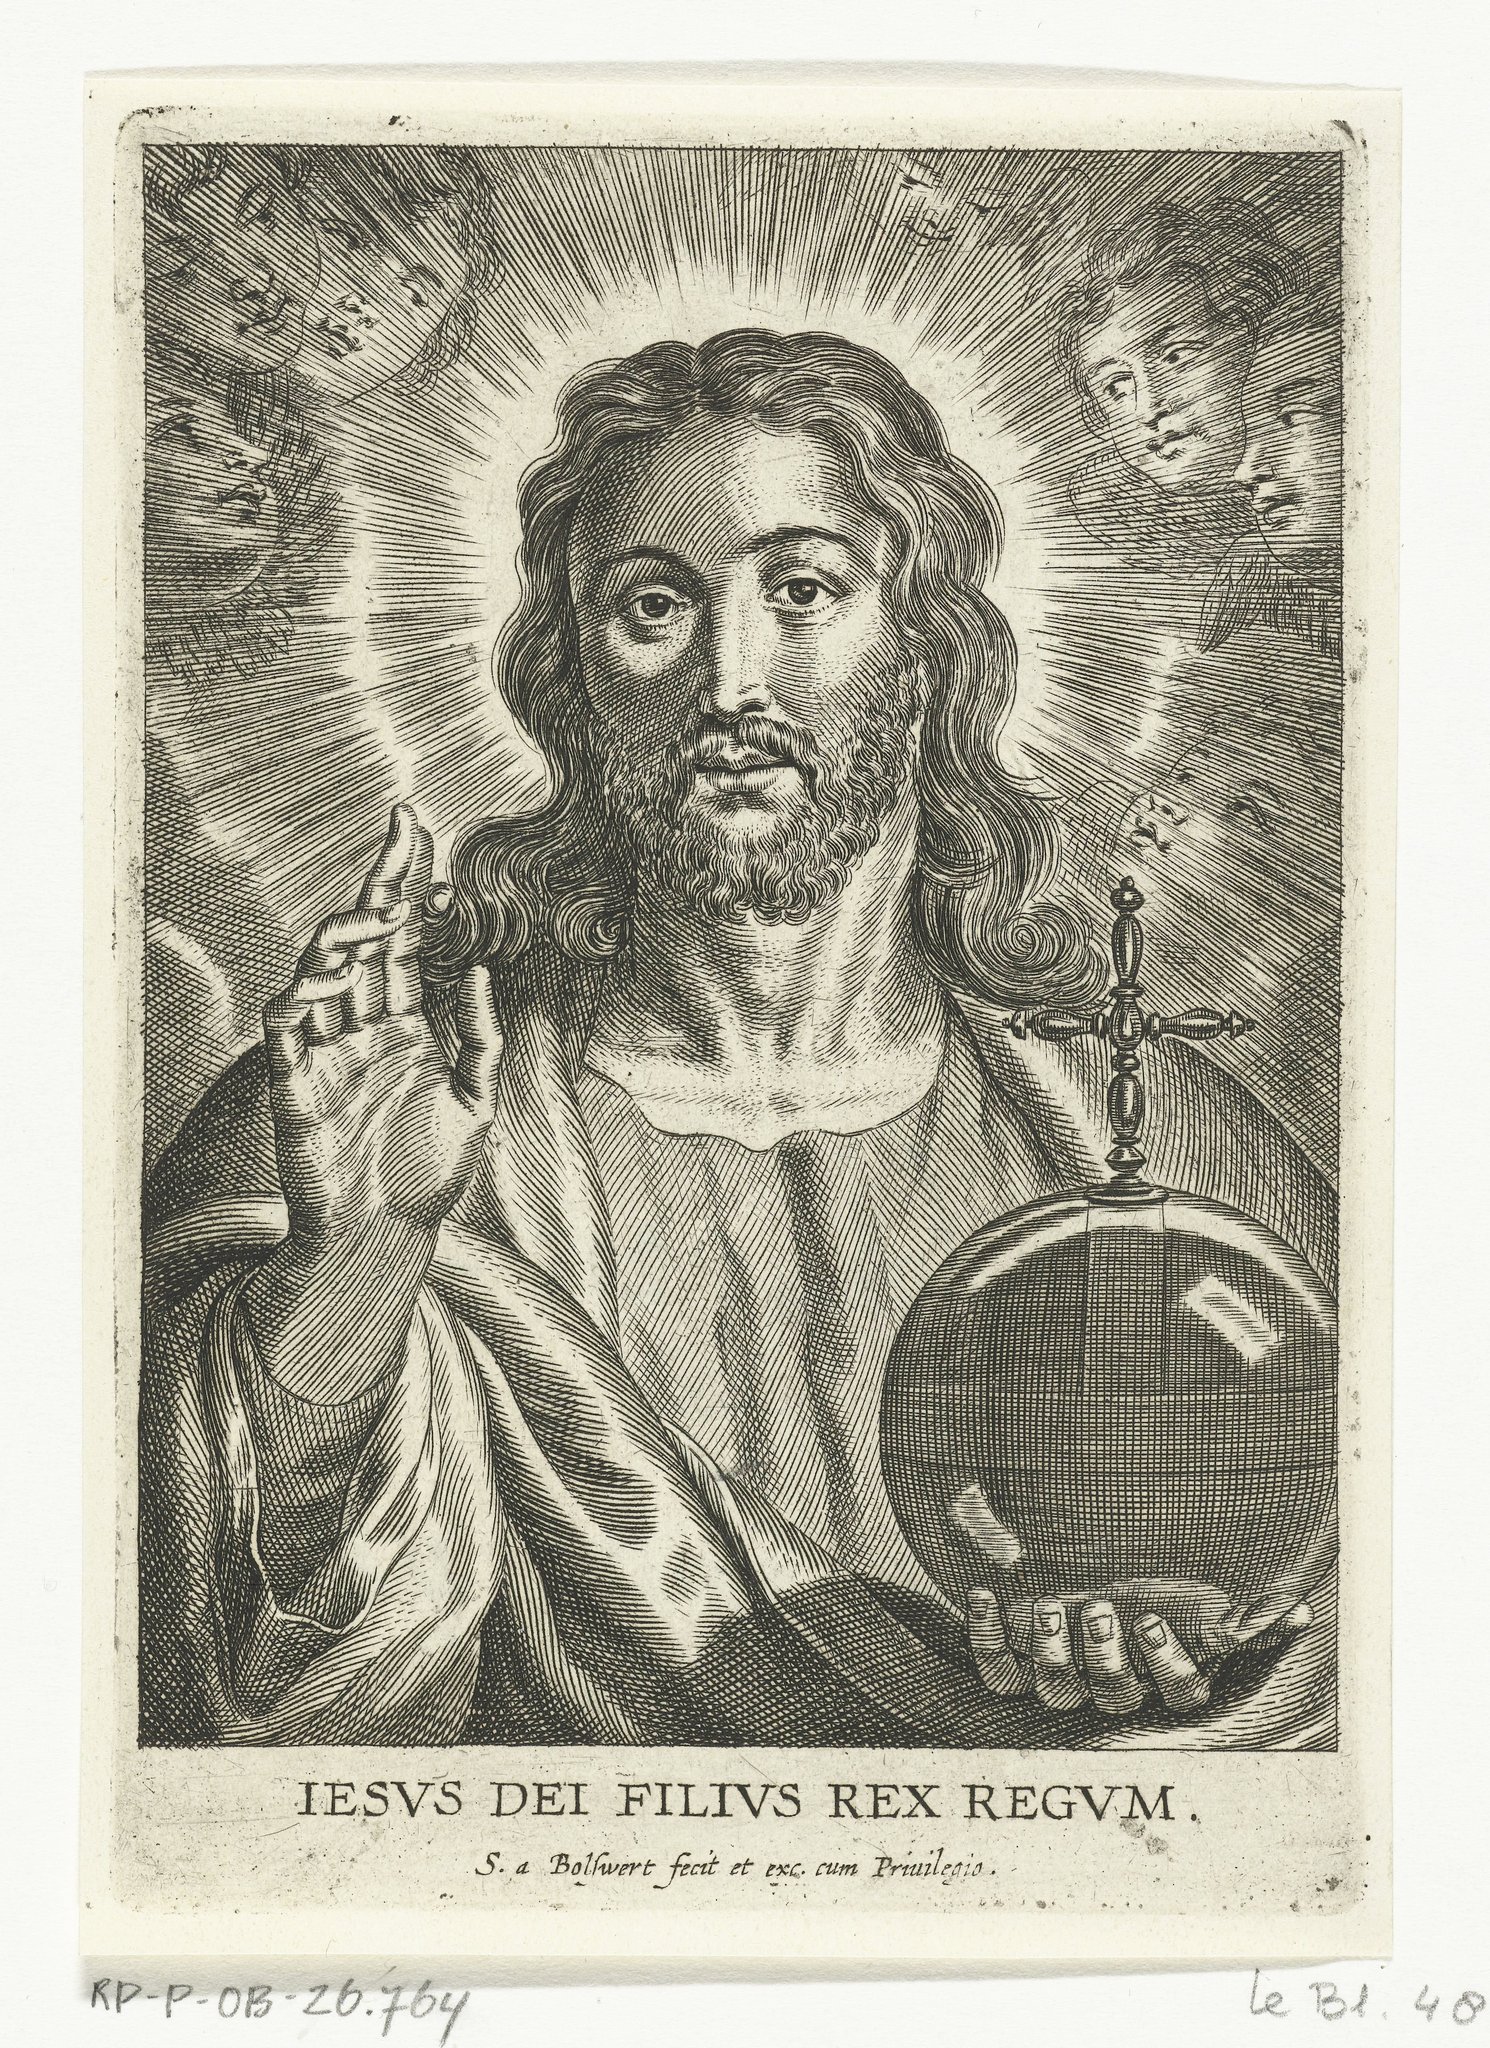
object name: print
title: Vélins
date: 1596-1659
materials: paper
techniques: engraving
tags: 'salvator mundi', making a blessing gesture; an orb in his hand or at his feet (+ angel(s))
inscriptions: collector's mark: Lugt 2228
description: Prent uit serie Vélins met negentig prenten naar ontwerp van Peter Paul Rubens. In de bronnen vinden we uiteenlopende gegevens over aantal en samenstelling van de serie. Hollstein hanteert het aantal van negentig prenten. De reeks Vélins in de collectie van het RMA bevat verschillende staten afkomstig uit meerdere uitgaven welke moeilijk te duiden zijn. Sommige dragen het originele adres van Schelte Adamsz. Bolswert als graveur en uitgever, op andere exemplaren is deze naam verwijderd (duidelijk zichtbaar!) en vervangen door de naam Cornelis Galle (II). De prenten met de naam van uitgever Galle zijn vaak opgewerkt. We treffen nog een andere naam van een uitgever bij enkele prent aan: Martien van den Enden. Herkomst uit meerdere uitgaven spreekt ook uit afwijkende opschriften in Nederlands en Latijn en variaties op dezelfde thema's welke misschien nooit langs elkaar in dezelfde serie gebruikt werden.